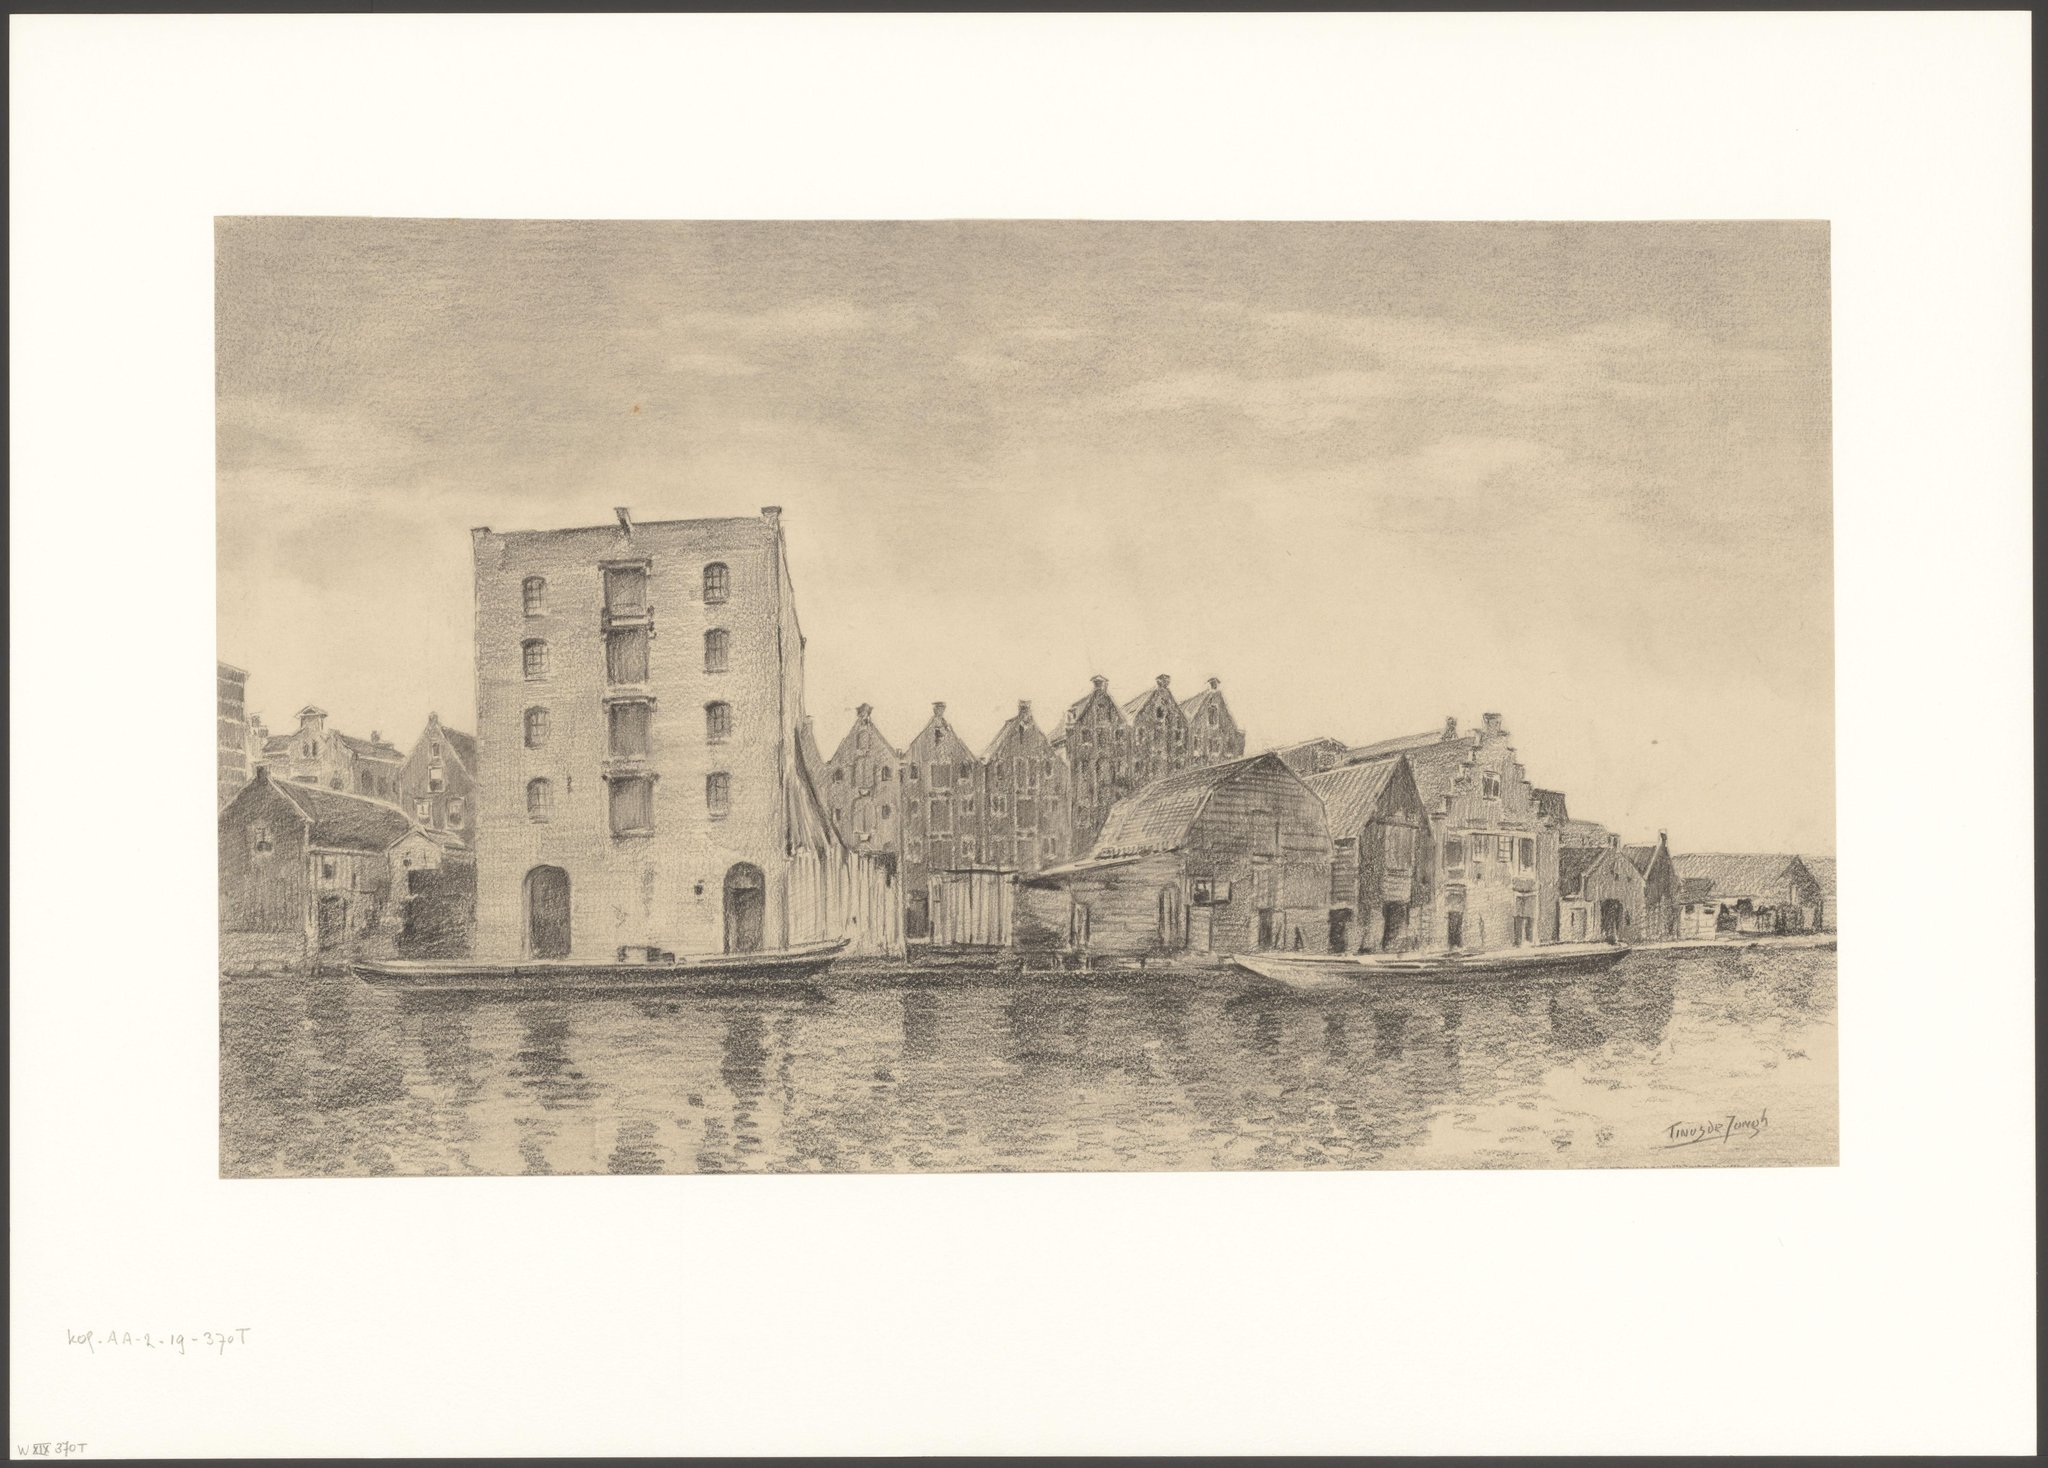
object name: drawing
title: Gezicht op het Prinseneiland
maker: tinus de jongh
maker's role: print maker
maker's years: 1885-1942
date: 1895-1942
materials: chalk, paper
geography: amsterdam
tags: sailing-ship, sailing-boat, city-view in general; 'veduta', canal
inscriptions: signature: ‘TinusdeJongh’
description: Tekening binnen de Atlas Van Eck ingedeeld op wijknummer 19.